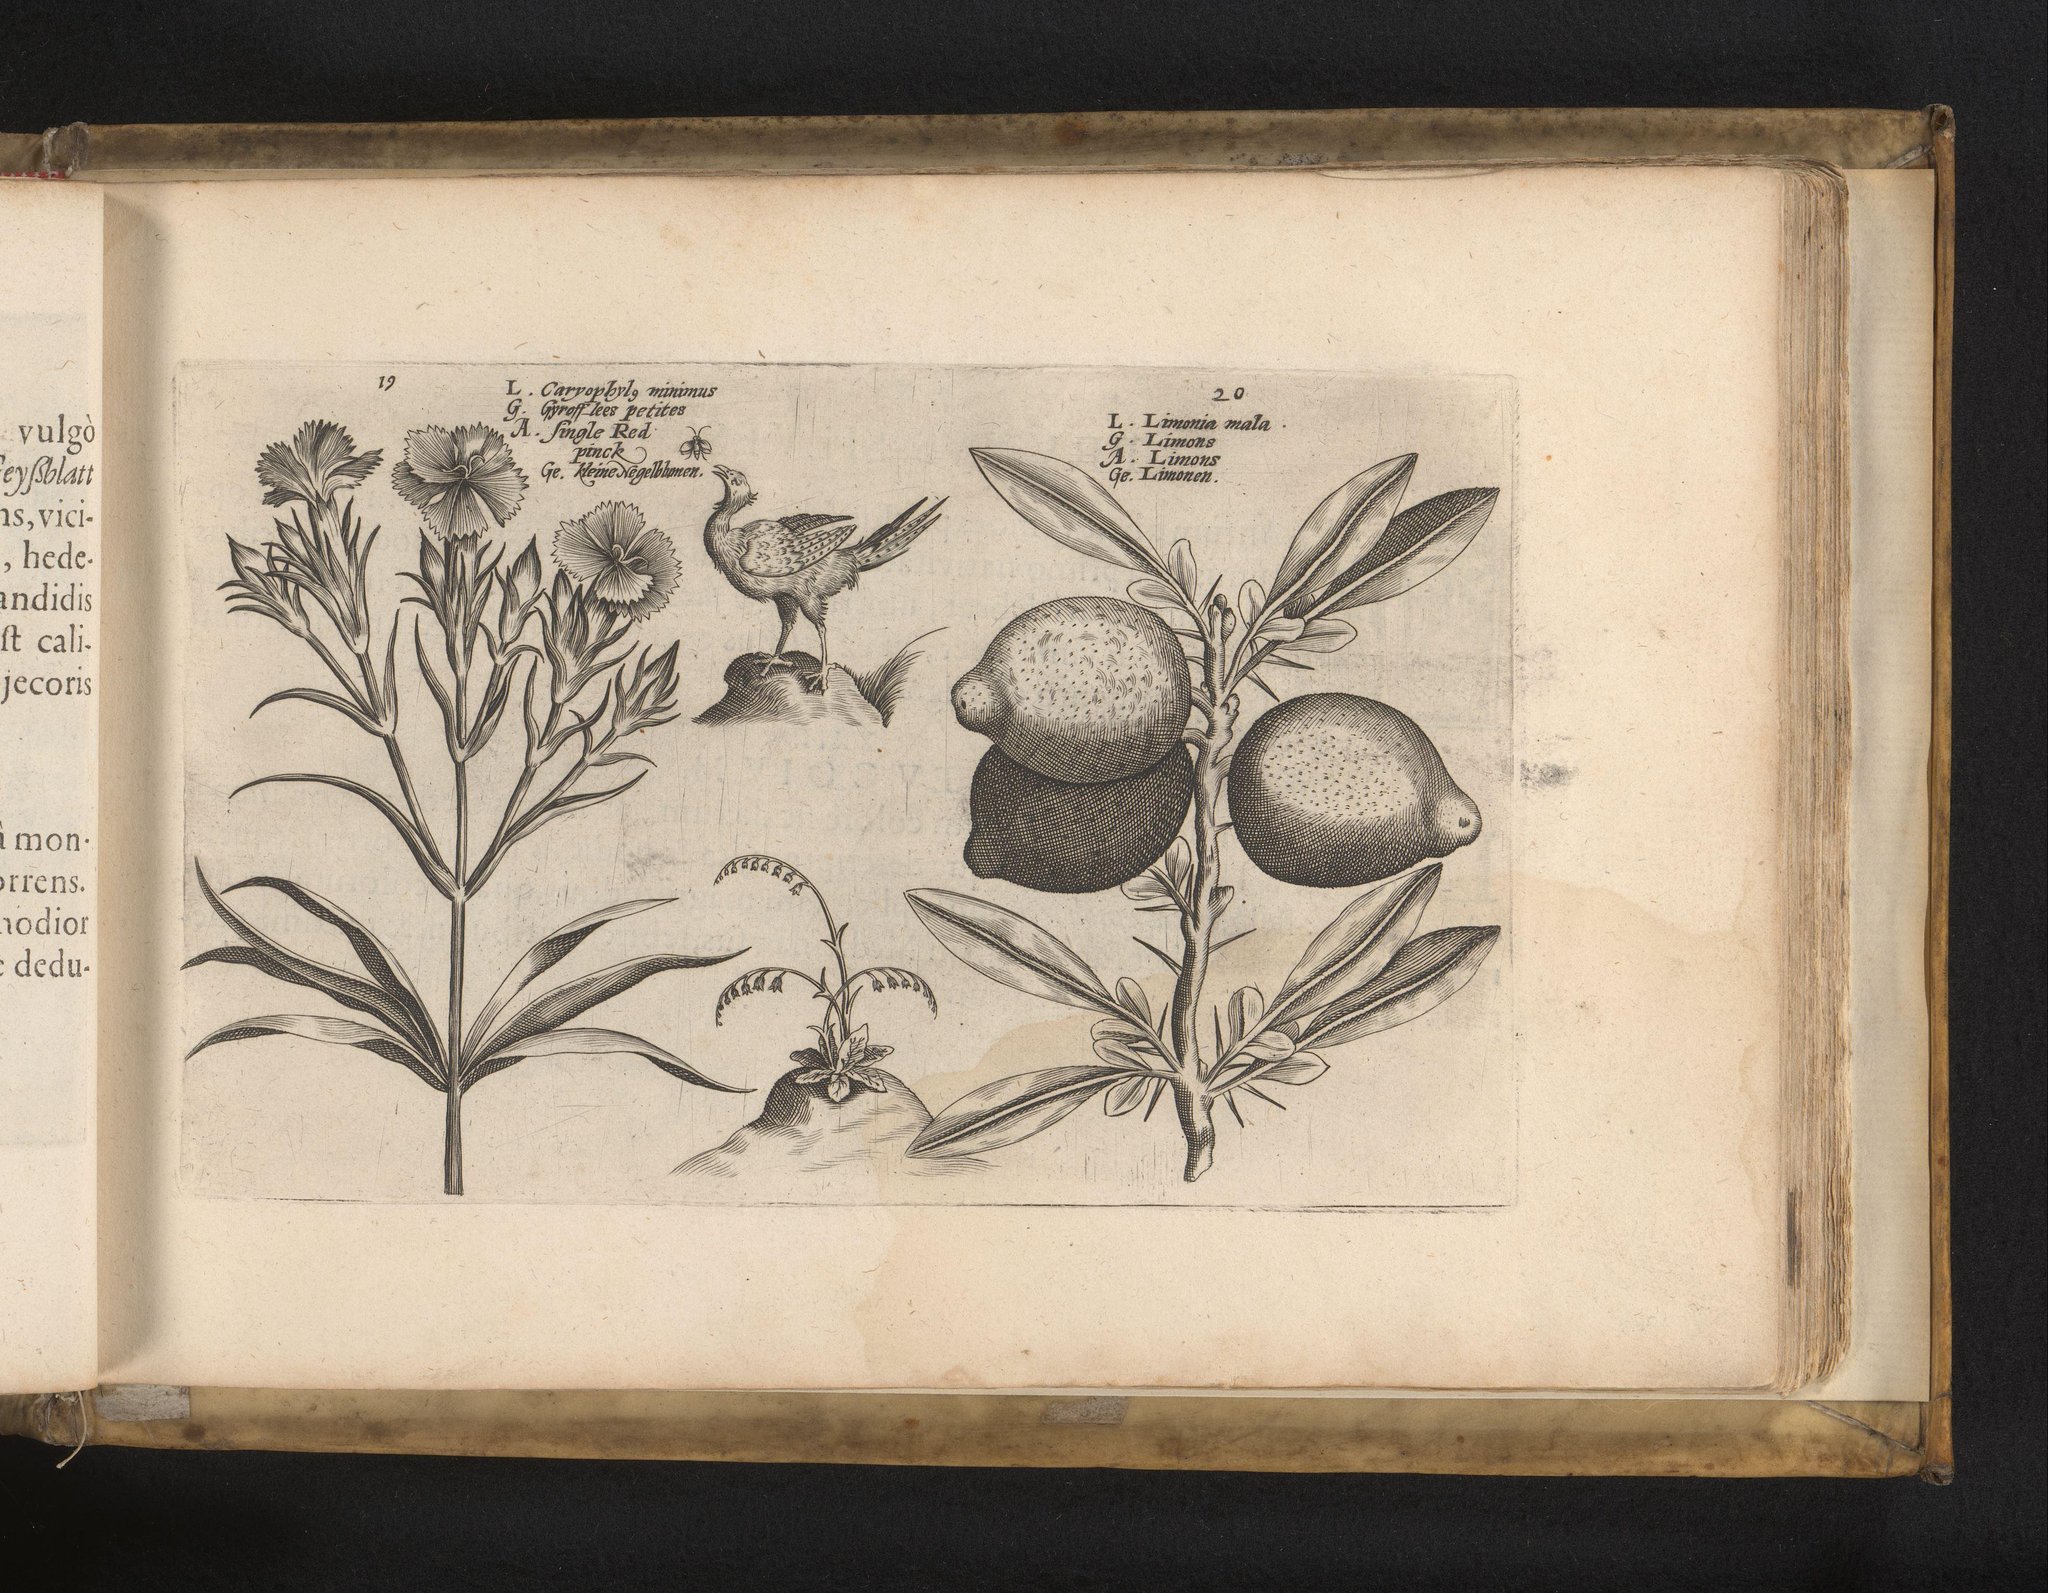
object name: page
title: Bloementuin, het andere deel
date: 1617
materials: paper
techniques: engraving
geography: arnhem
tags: flowers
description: Prent uit: Passe, Crispijn van de (II). Hortus floridus in quo rariorum & minus vulgarium florum icones ad vivam veramque formam. Arnhem: Johannes Janssonius, 1617.